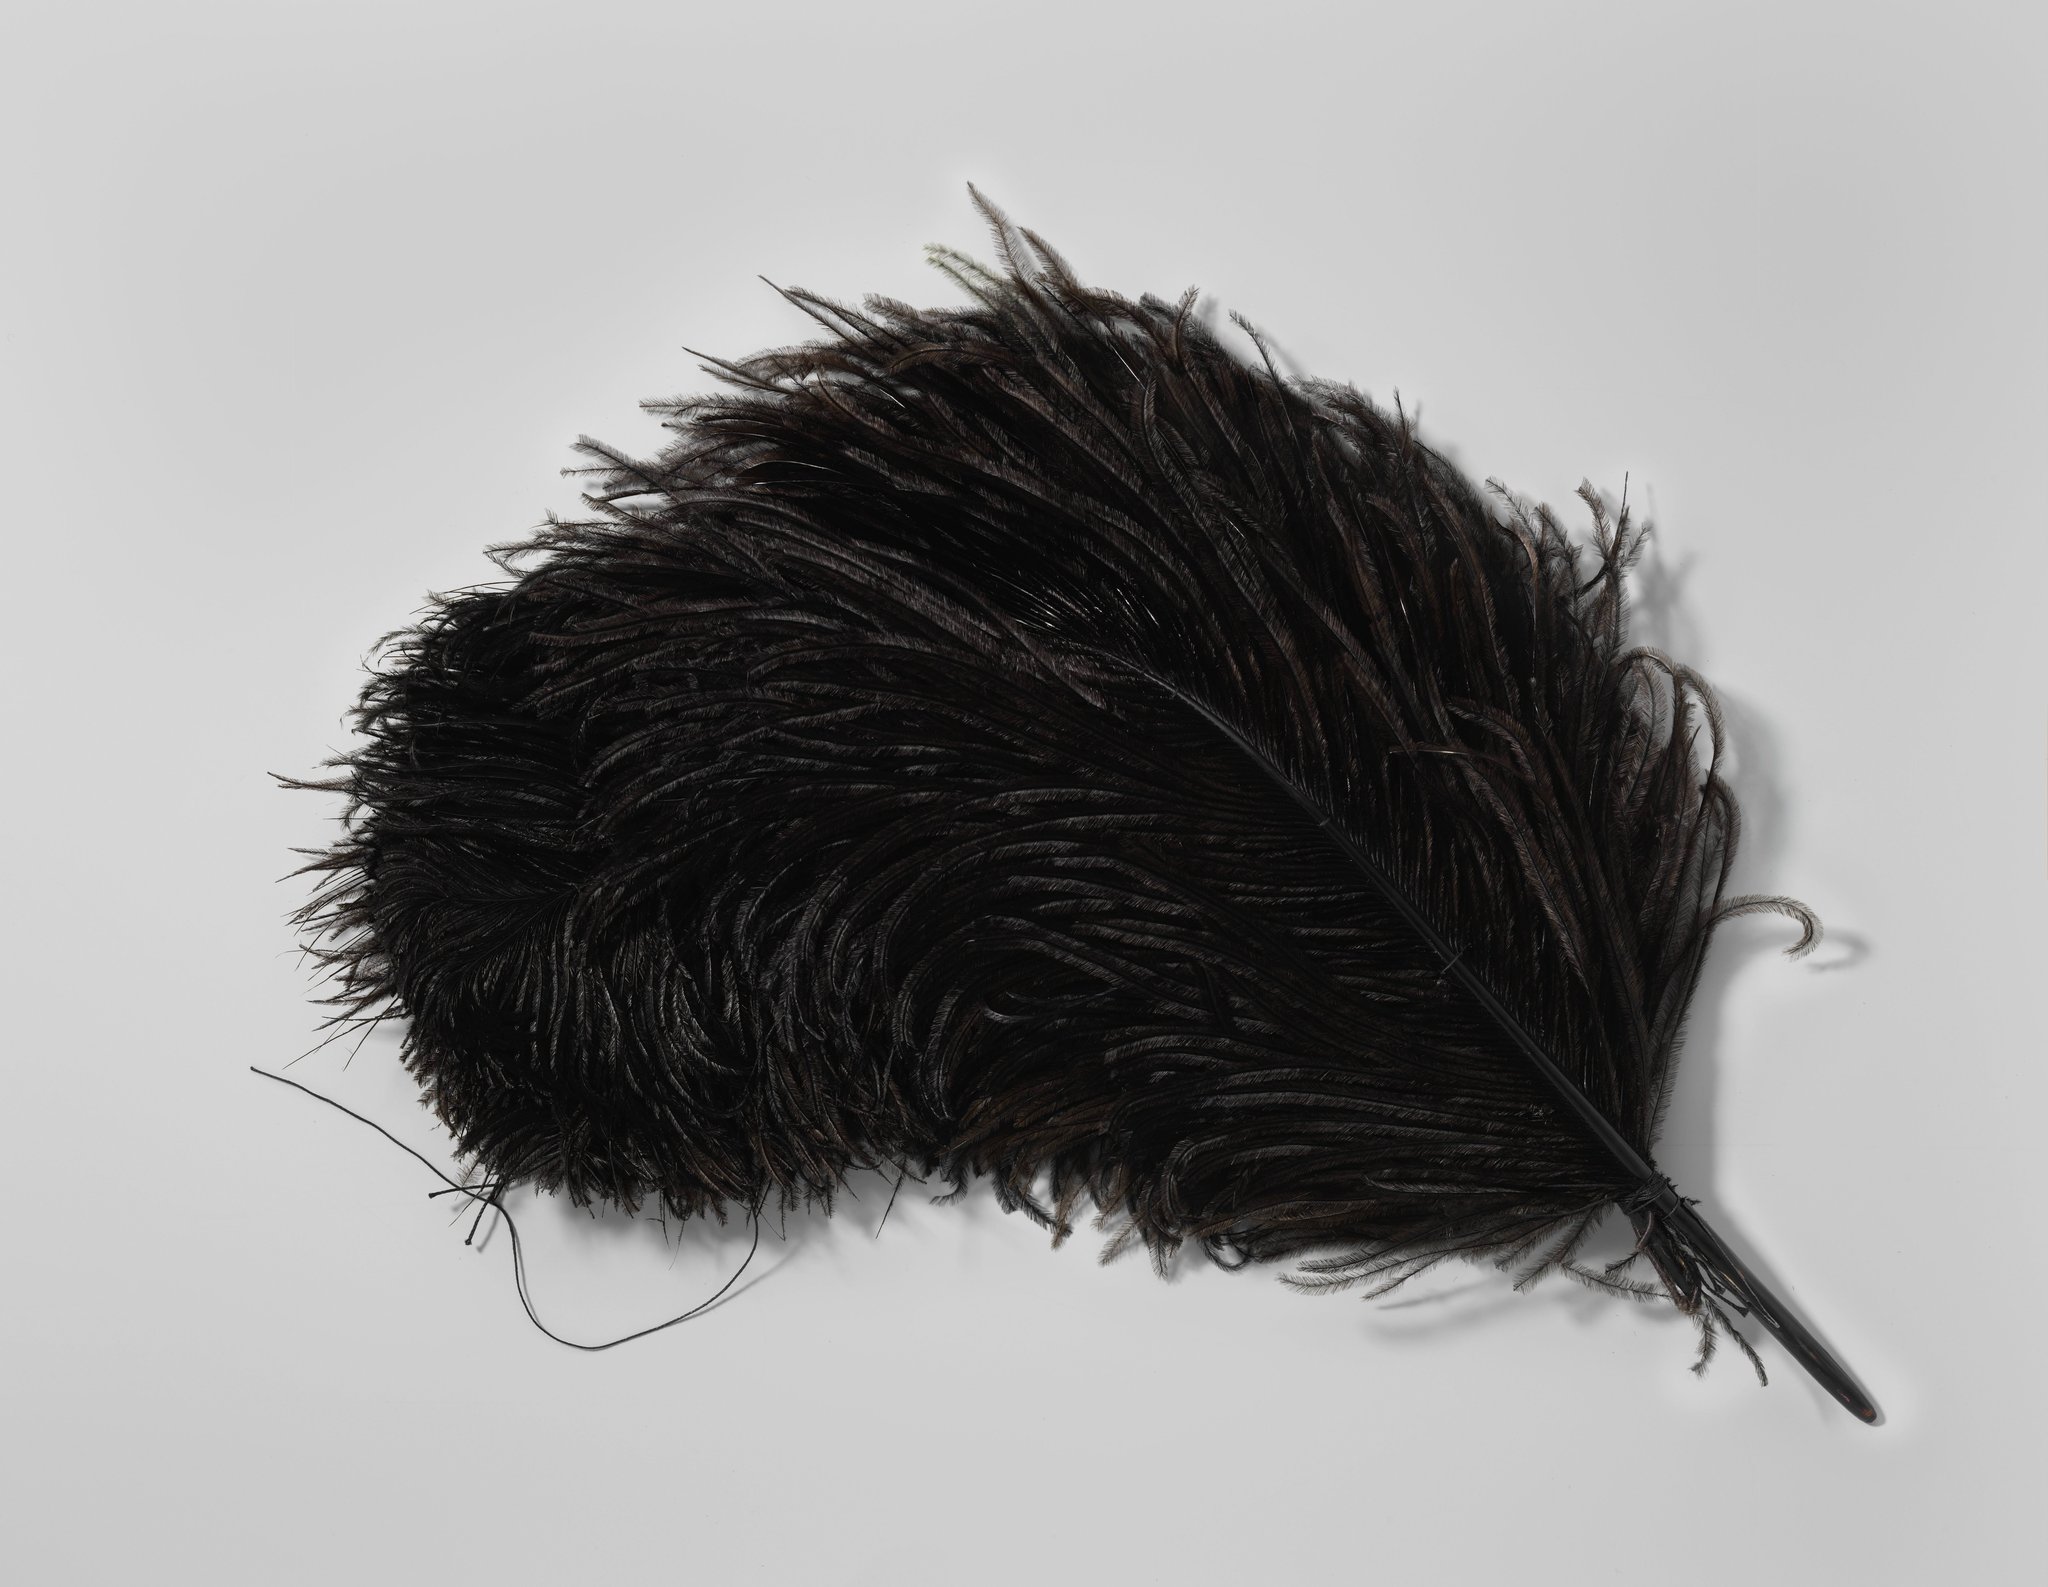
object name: hoedenveer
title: Toef van drie zwarte struisveren met sterk gekruld einde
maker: Anonymous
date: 1920-1930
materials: ostrich feather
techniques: painting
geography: nice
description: Toef van drie zwarte struisveren met sterk gekruld einde.